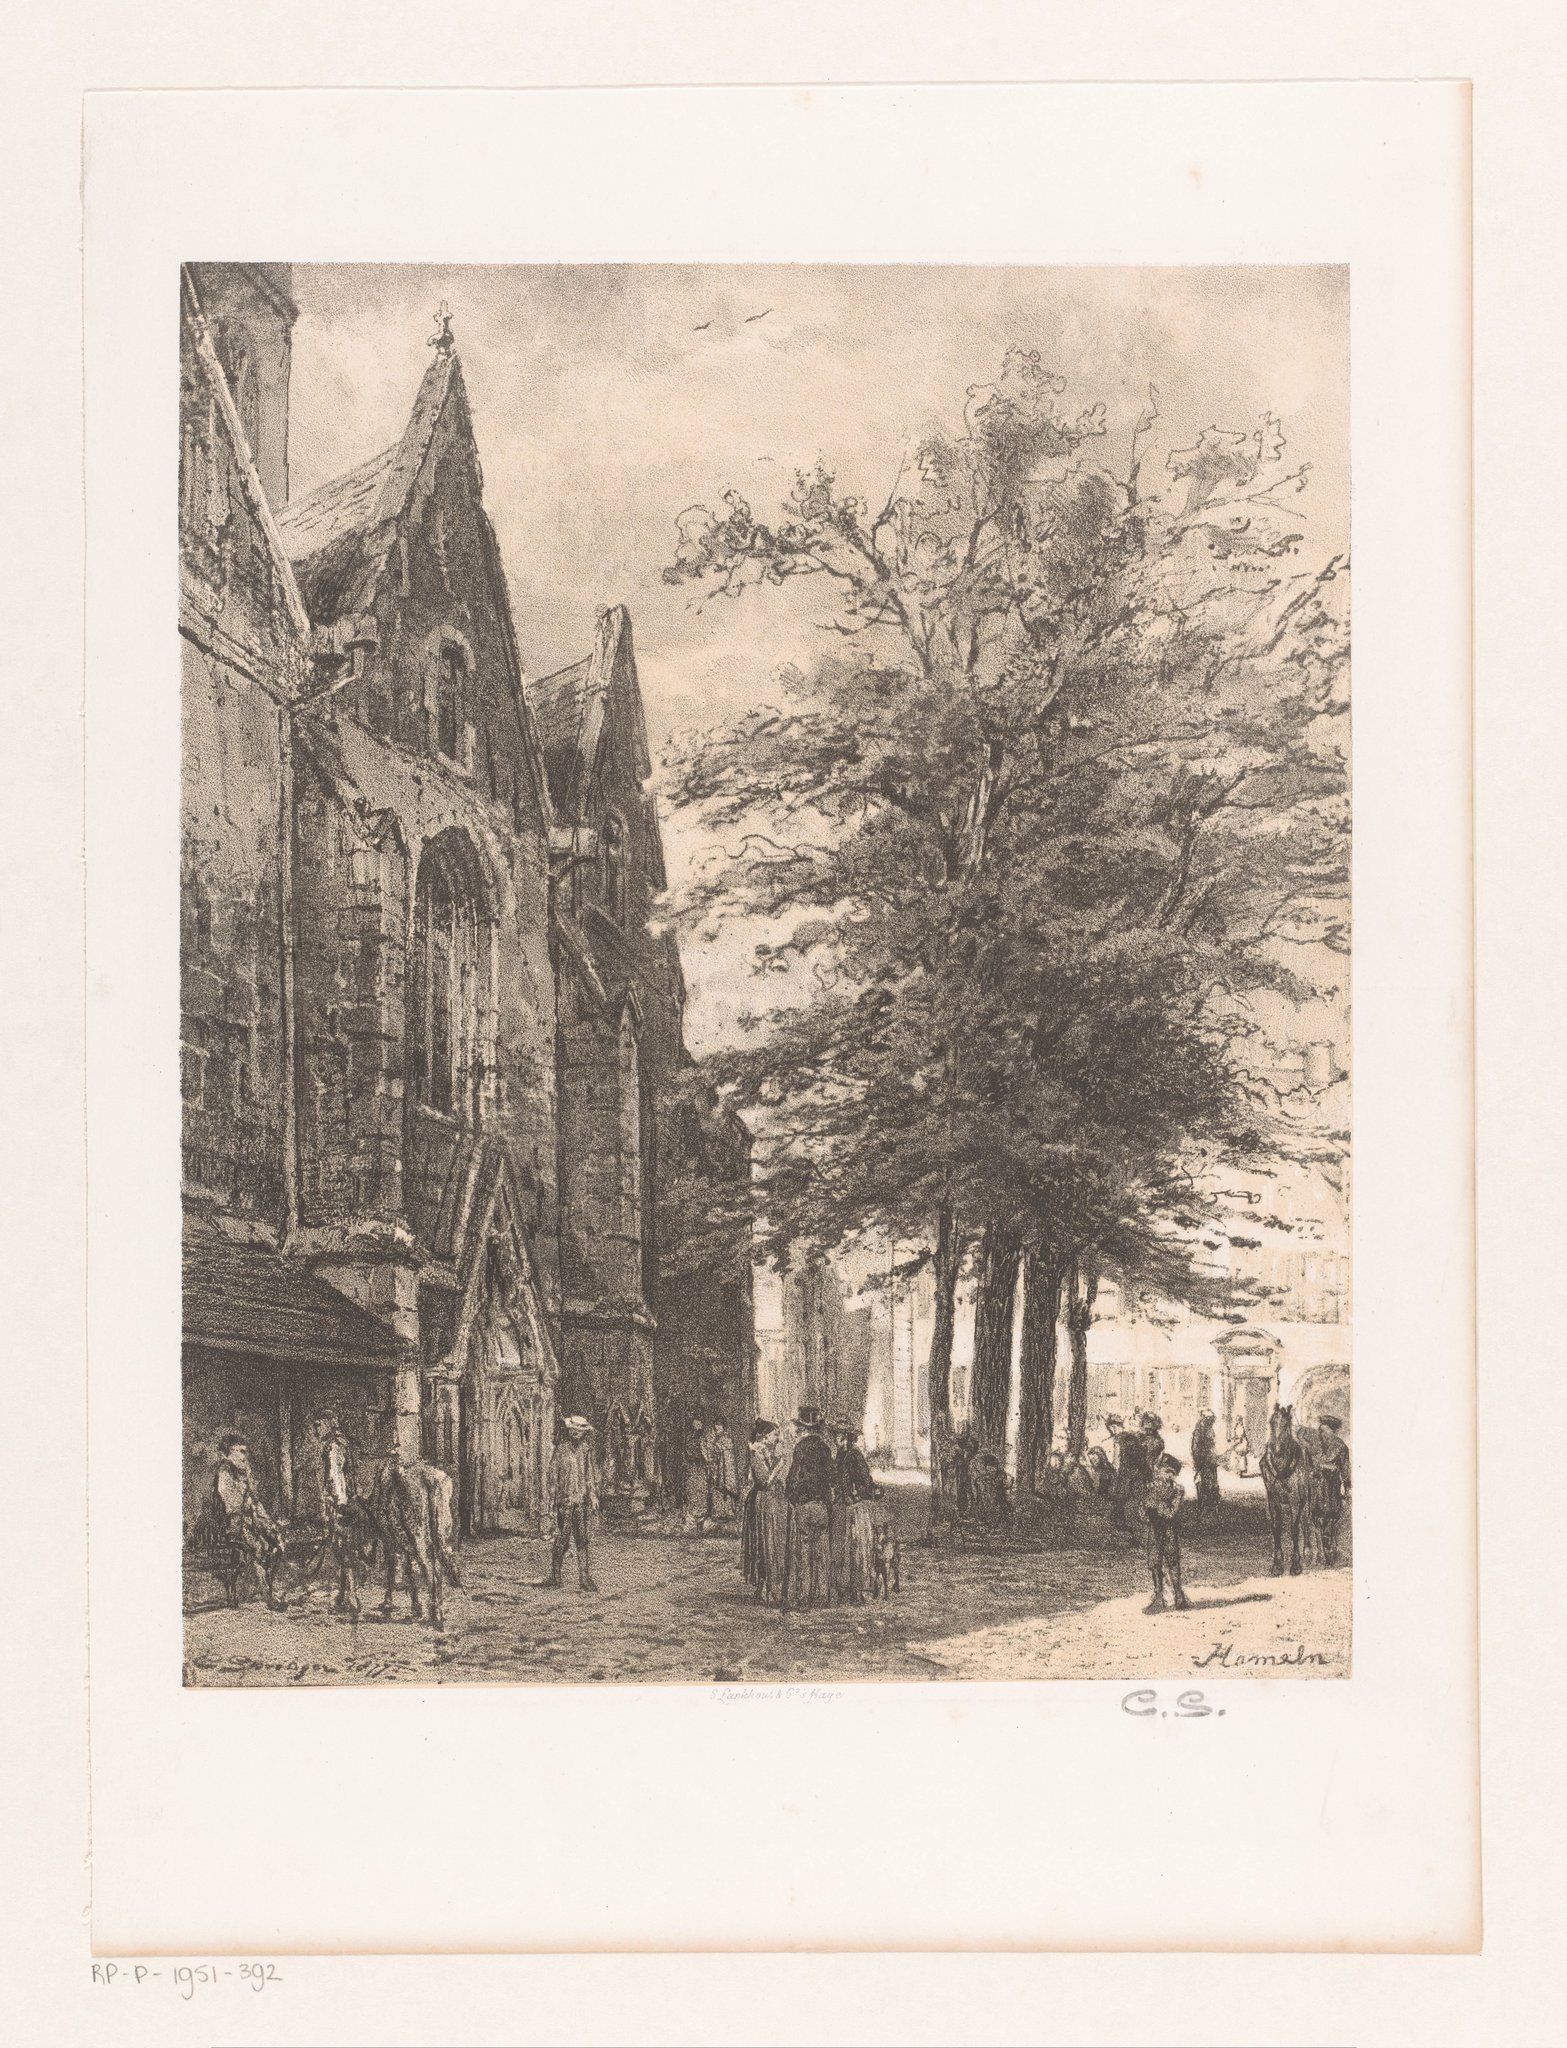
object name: print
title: Mensen voor Marktkerk te Hamelen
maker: cornelis springer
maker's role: draughtsman, painter, print maker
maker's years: 1817-1891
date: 1877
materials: paper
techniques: tone lithography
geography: the hague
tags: church (exterior)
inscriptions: collector's mark: Lugt 2228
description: Mensen staan voor de noordelijk ingangspartij van de Marktkerk.